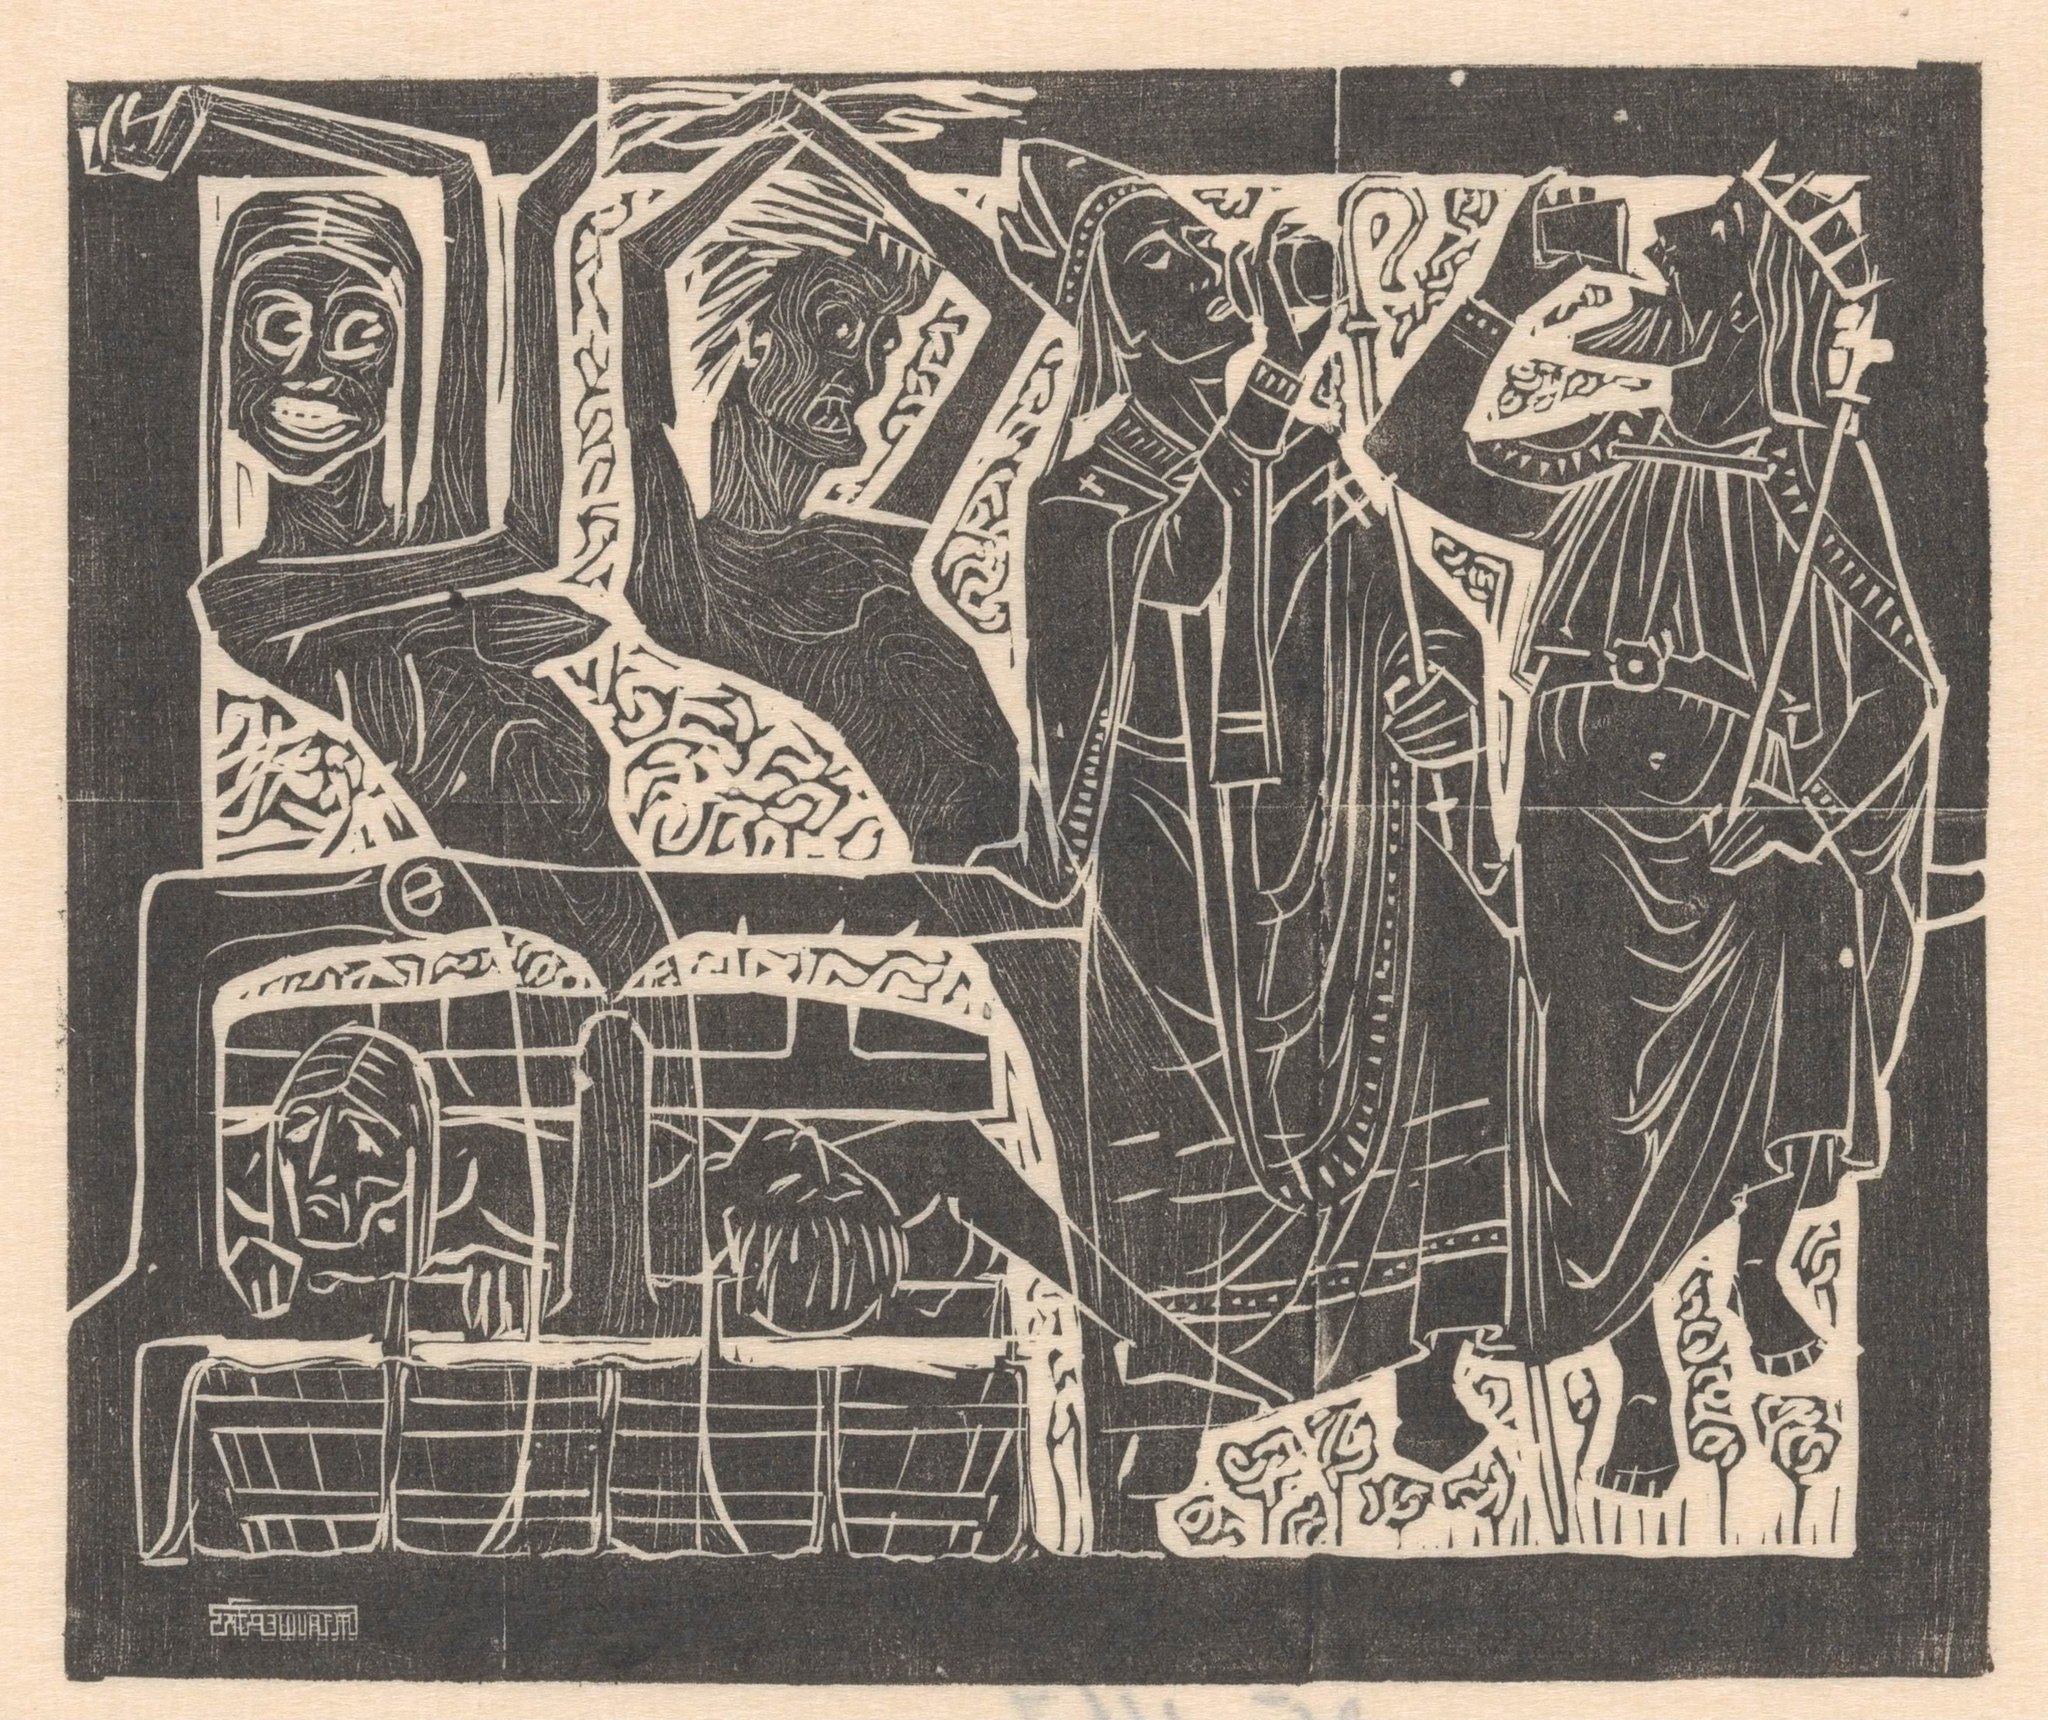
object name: illustration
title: Wijnpers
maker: mathieu lauweriks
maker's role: designer, draughtsman, print maker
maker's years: 1864-1932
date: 1894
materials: paper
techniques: woodcut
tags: personifications of countries, nations, states, districts, etc., wine-press, the church personified, 'ecclesia', usually with chalice and banner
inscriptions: collector's mark: Lugt 2228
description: Links een wijnpers waarmee het bloed van twee mensen wordt uitgeperst. Bij de pers twee dansende naakte figuren. Rechts staan een bisschop en een koning, als personificaties van de Kerk en de Staat, te drinken.